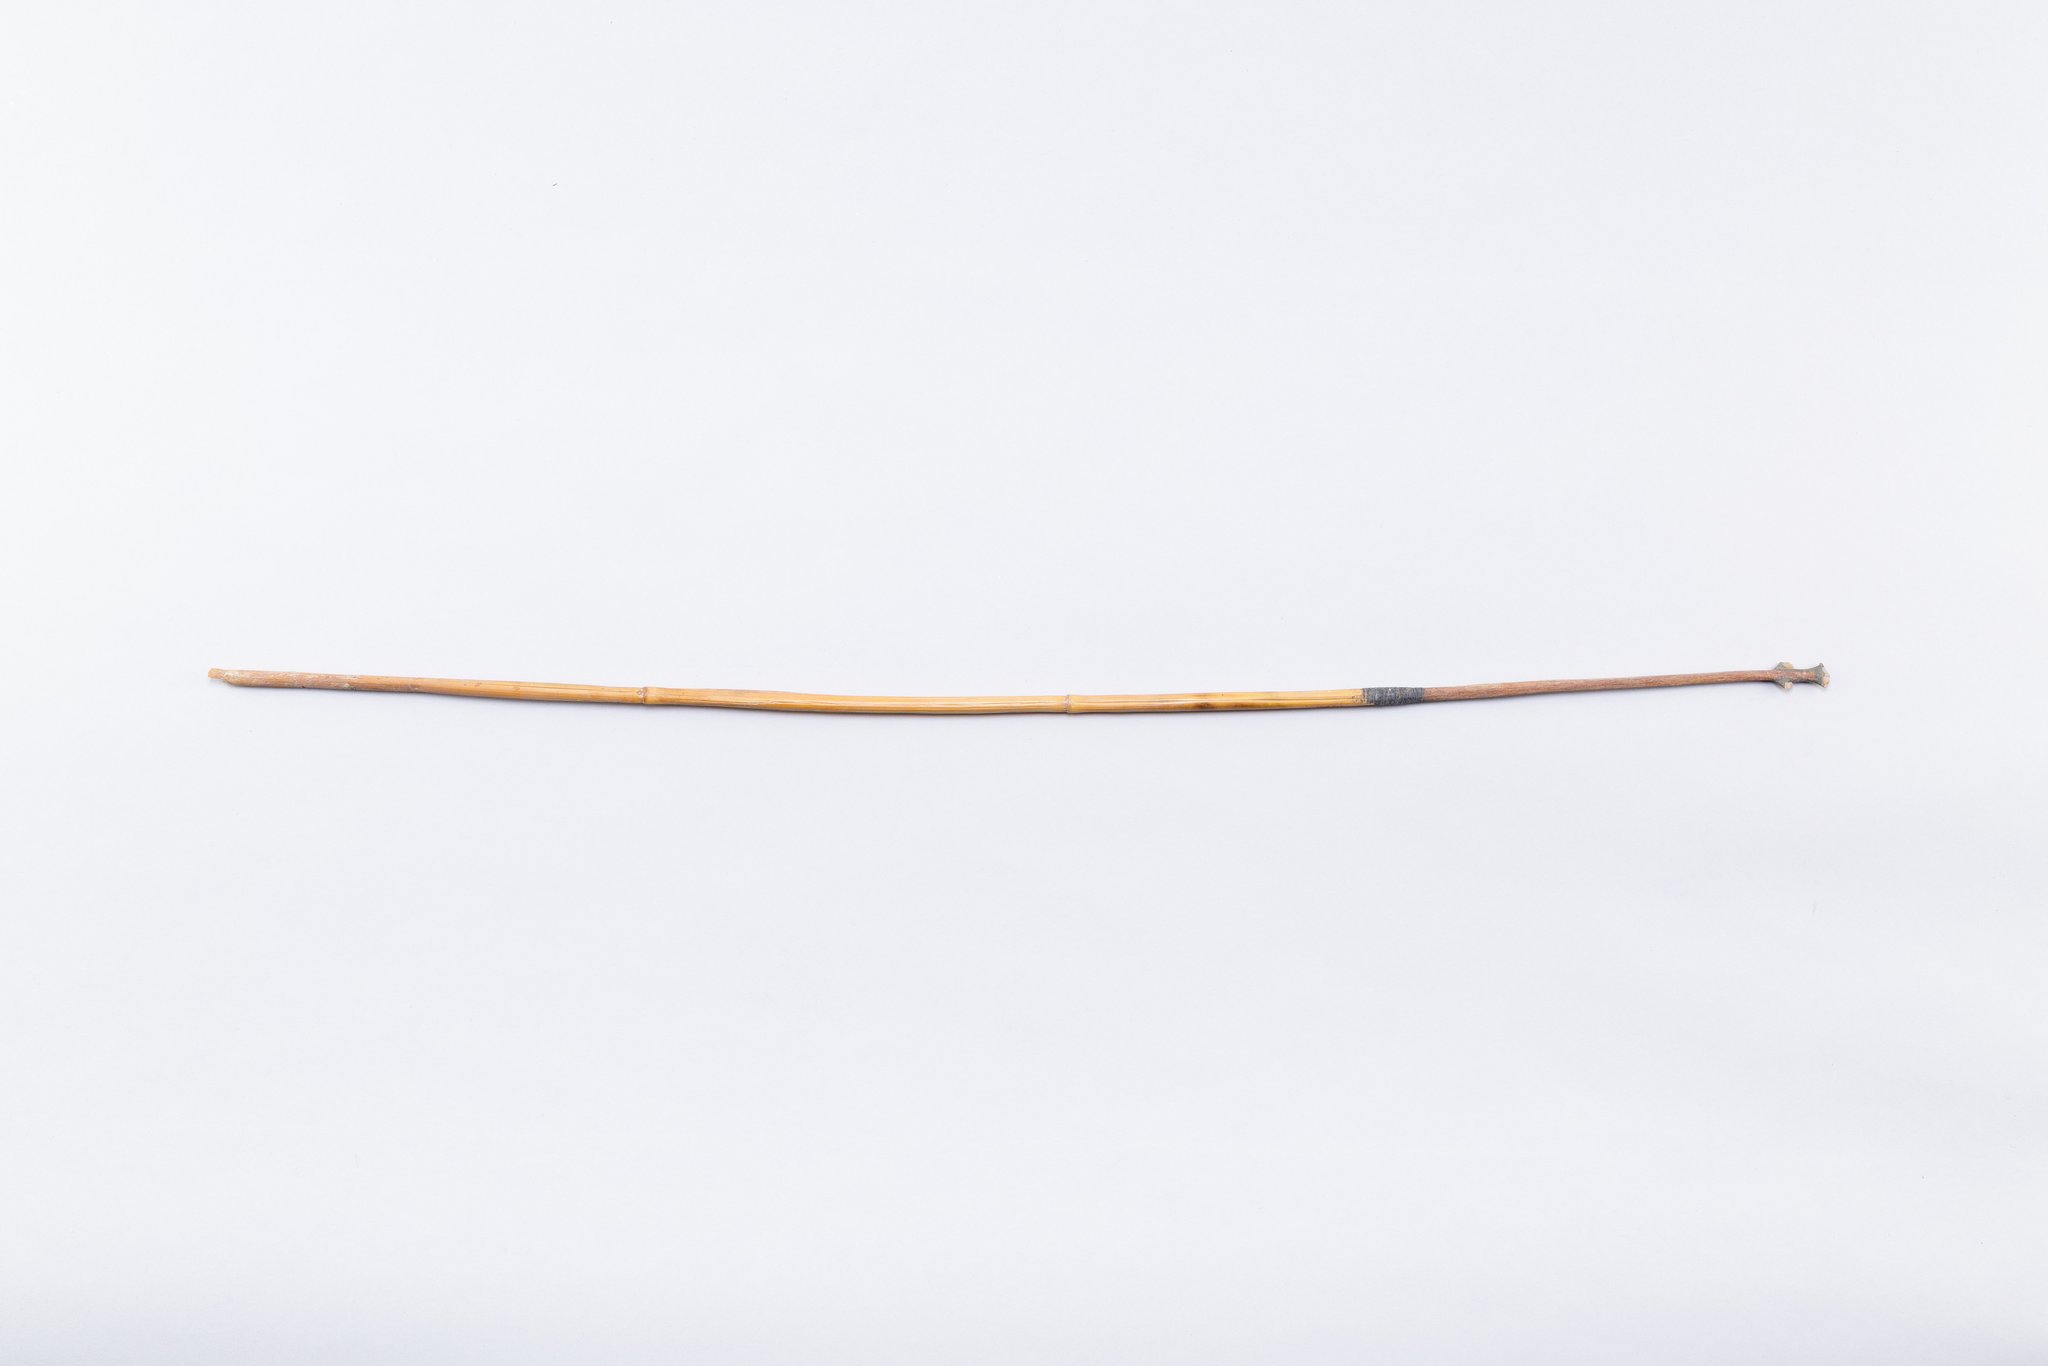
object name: arrow, arrowhead, adhesive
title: Arrow with composite stone tip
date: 1479-1458 BCE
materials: quartz, wood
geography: egypt